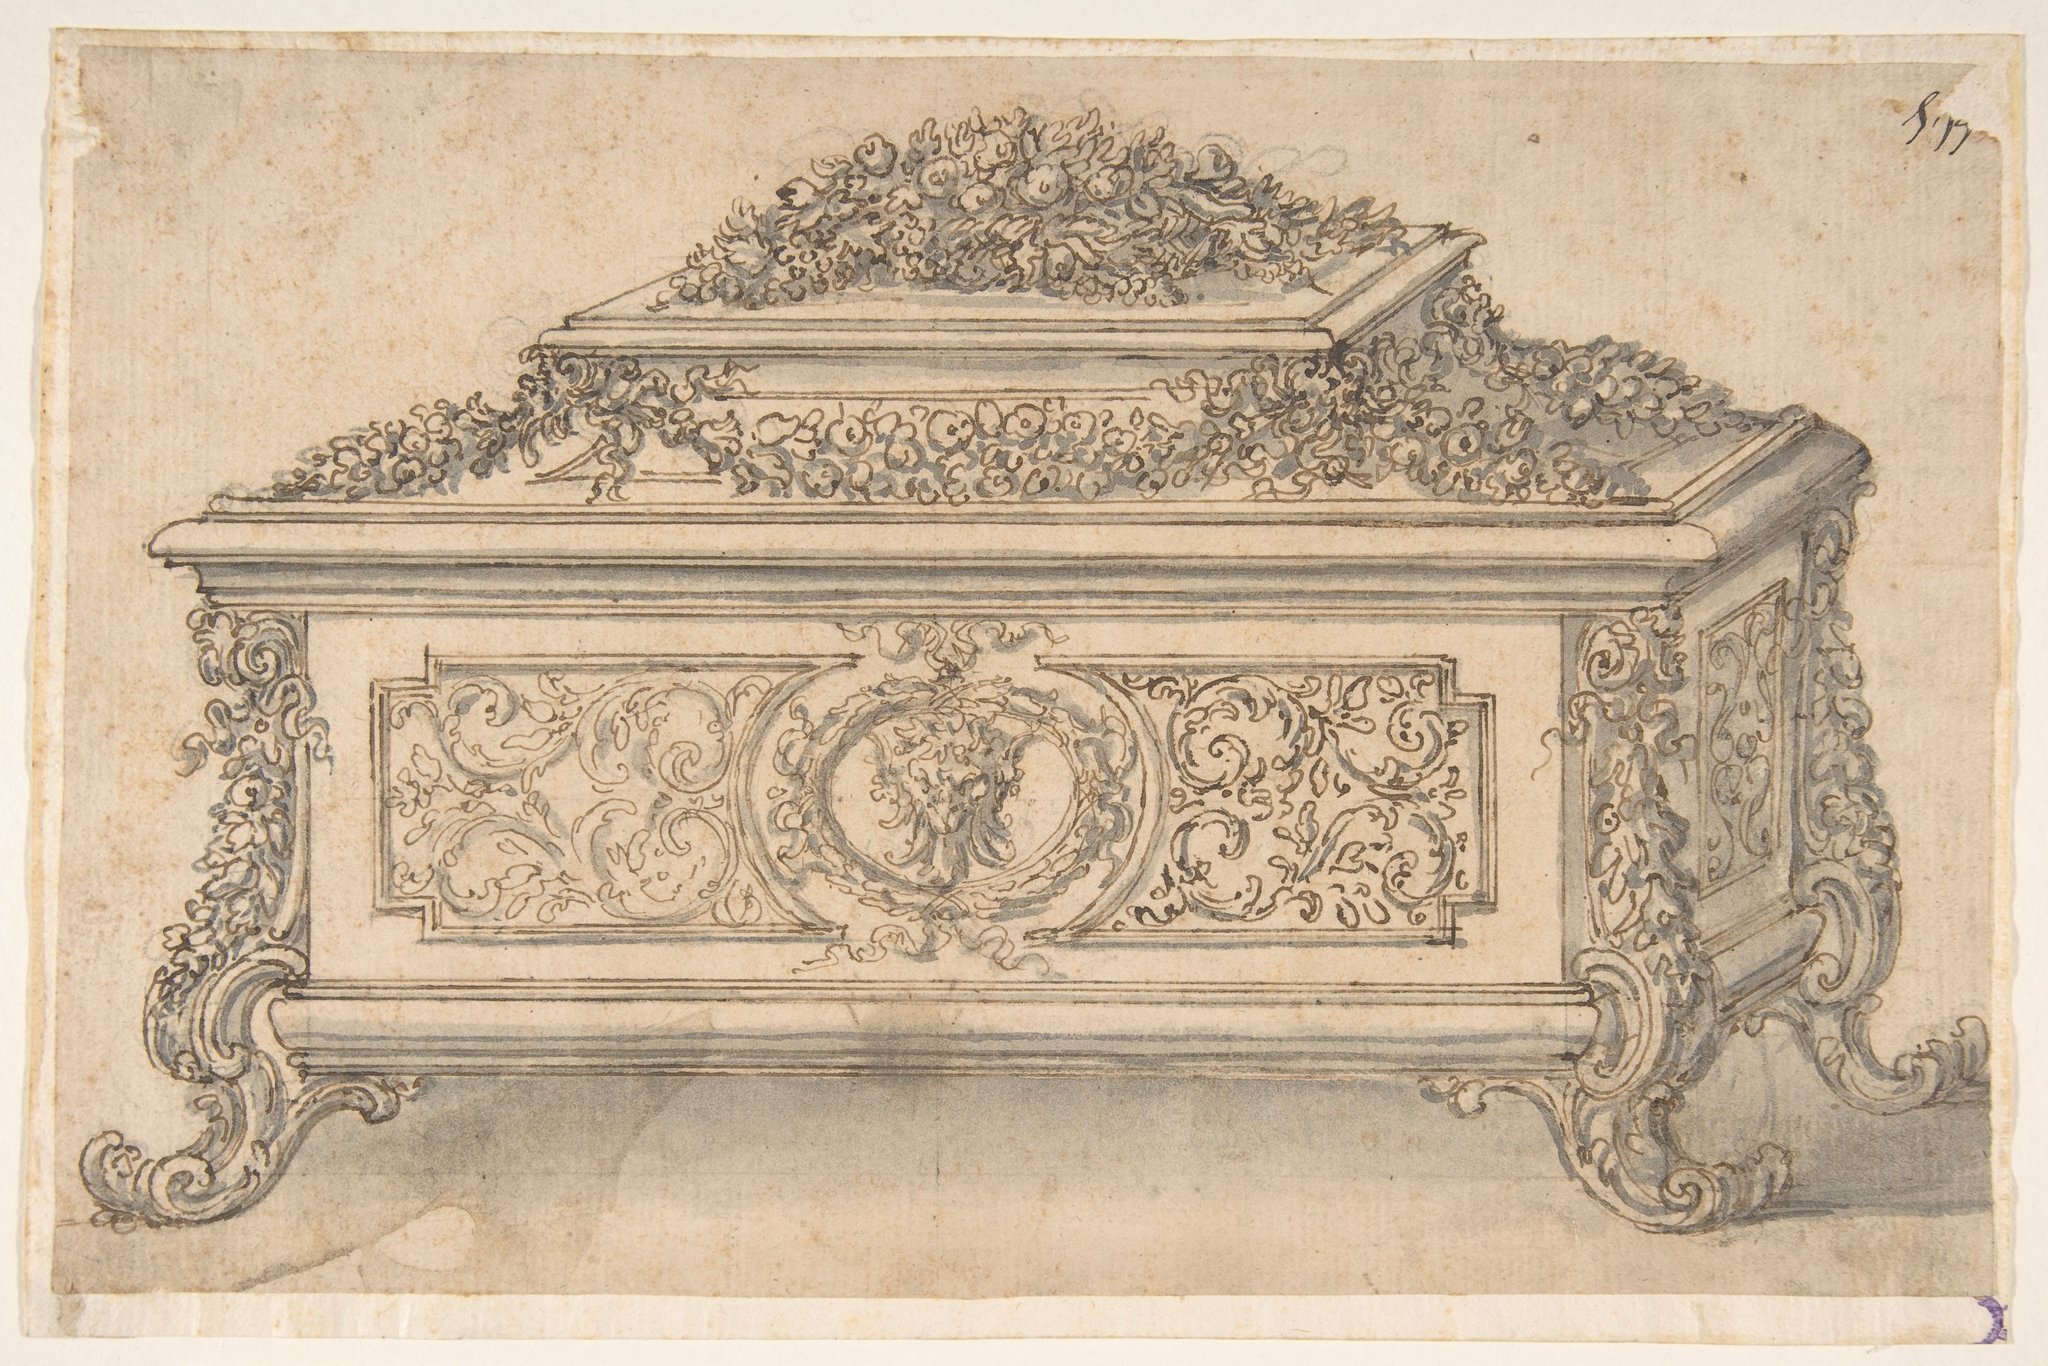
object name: drawing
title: Design for an Casket heavily decorated Foliate Scrolls, Garlands and a Satyr Mask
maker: giovanni battista foggini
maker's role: artist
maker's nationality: italian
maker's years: 1652-1725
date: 1672-1725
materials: graphite, ink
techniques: brush, pen, wash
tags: masks,ornament,satyrs,wreaths,chests